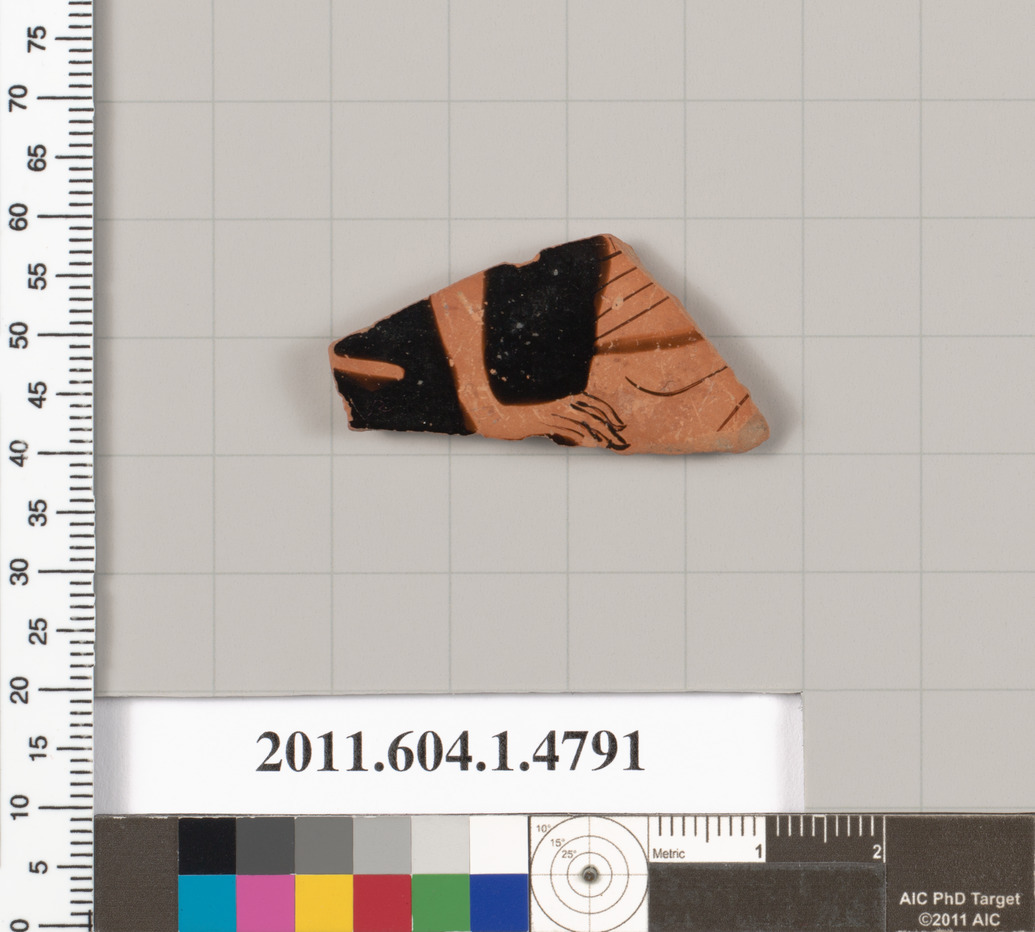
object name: kylix fragment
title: Terracotta fragment of a kylix (drinking cup)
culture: greek, attic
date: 475-451 BCE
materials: terracotta